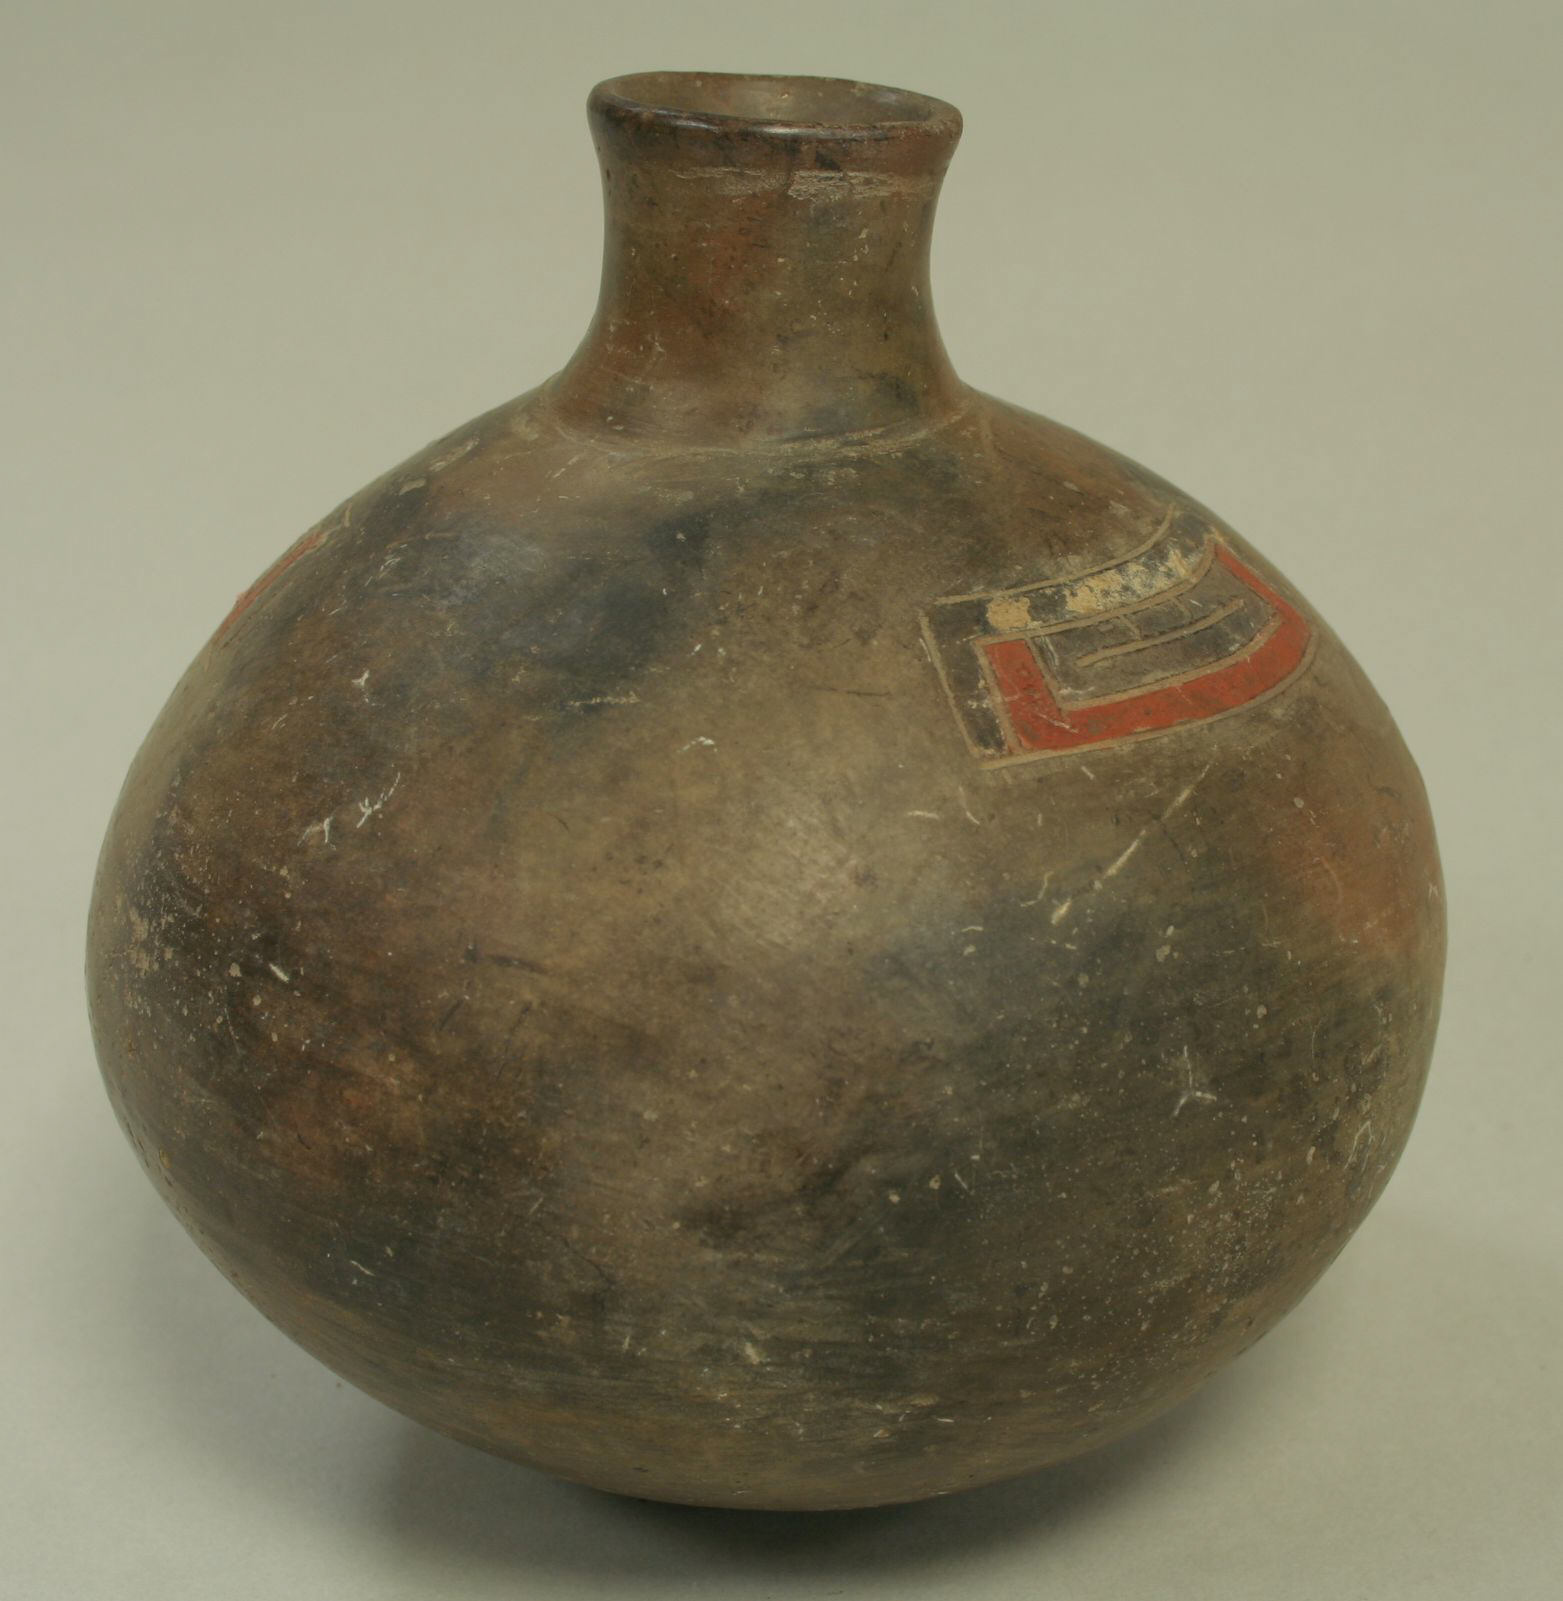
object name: bottle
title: Single Spout Bottle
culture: paracas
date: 500-201 BCE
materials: ceramic, pigment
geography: peru